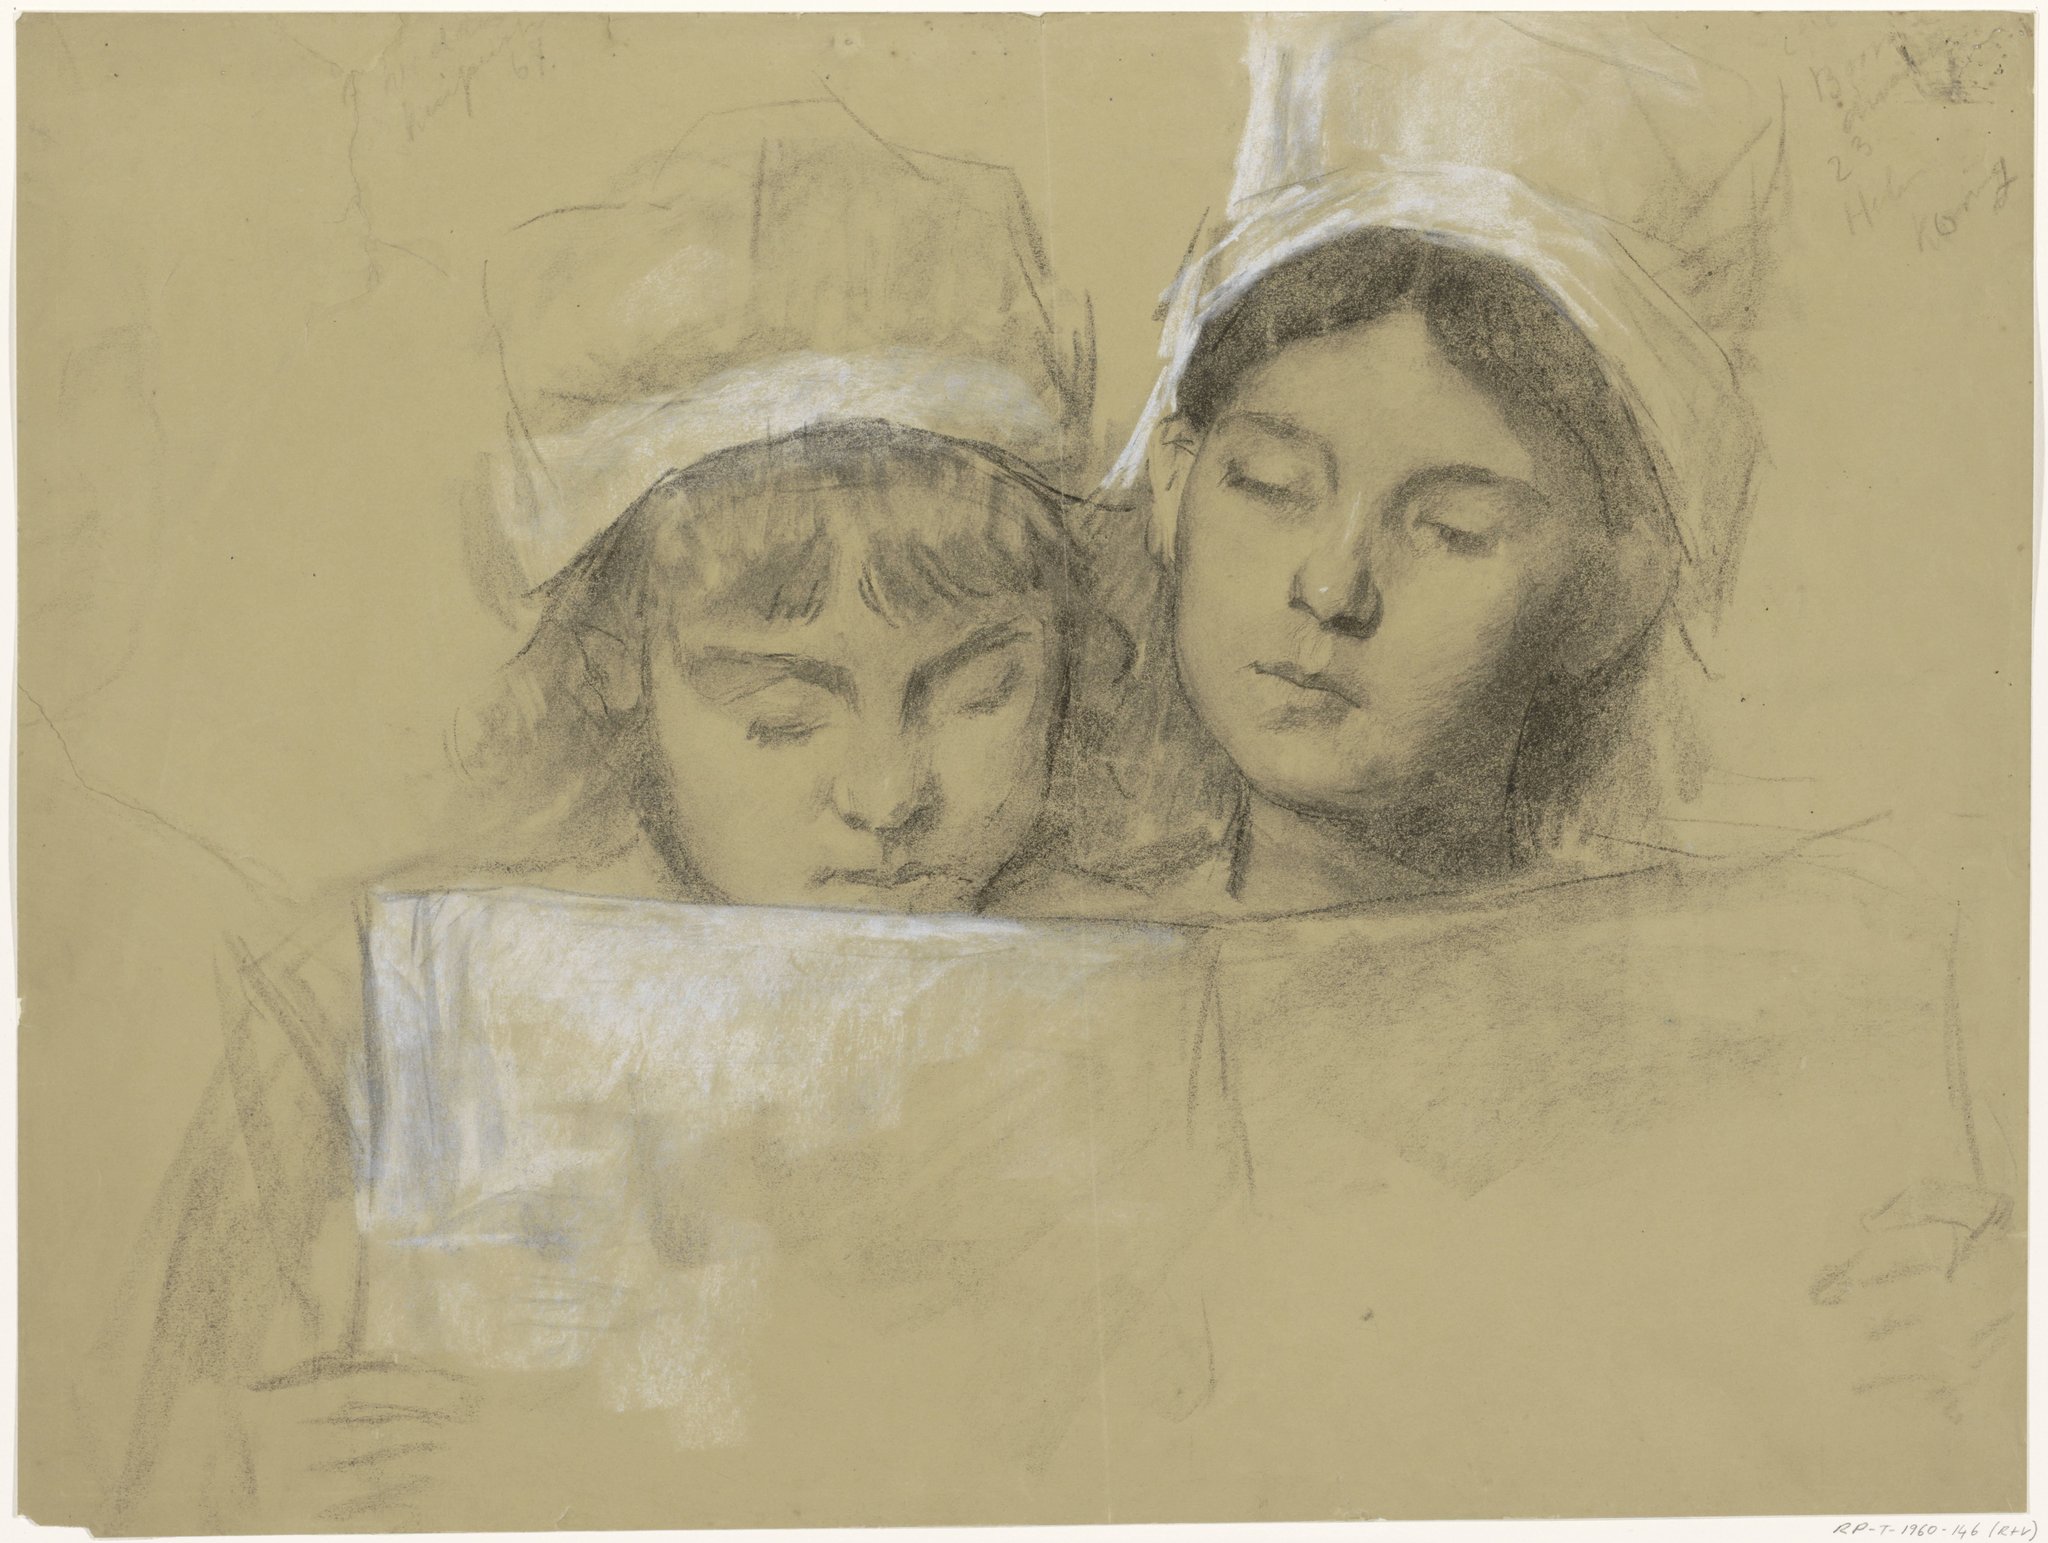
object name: drawing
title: Twee meisjes met witte mutsen, lezend in een boek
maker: thérèse schwartze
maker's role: draughtsman, painter, print maker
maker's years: 1851-1918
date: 1861-1918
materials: chalk, charcoal, paper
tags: reading, anonymous historical person portrayed alone